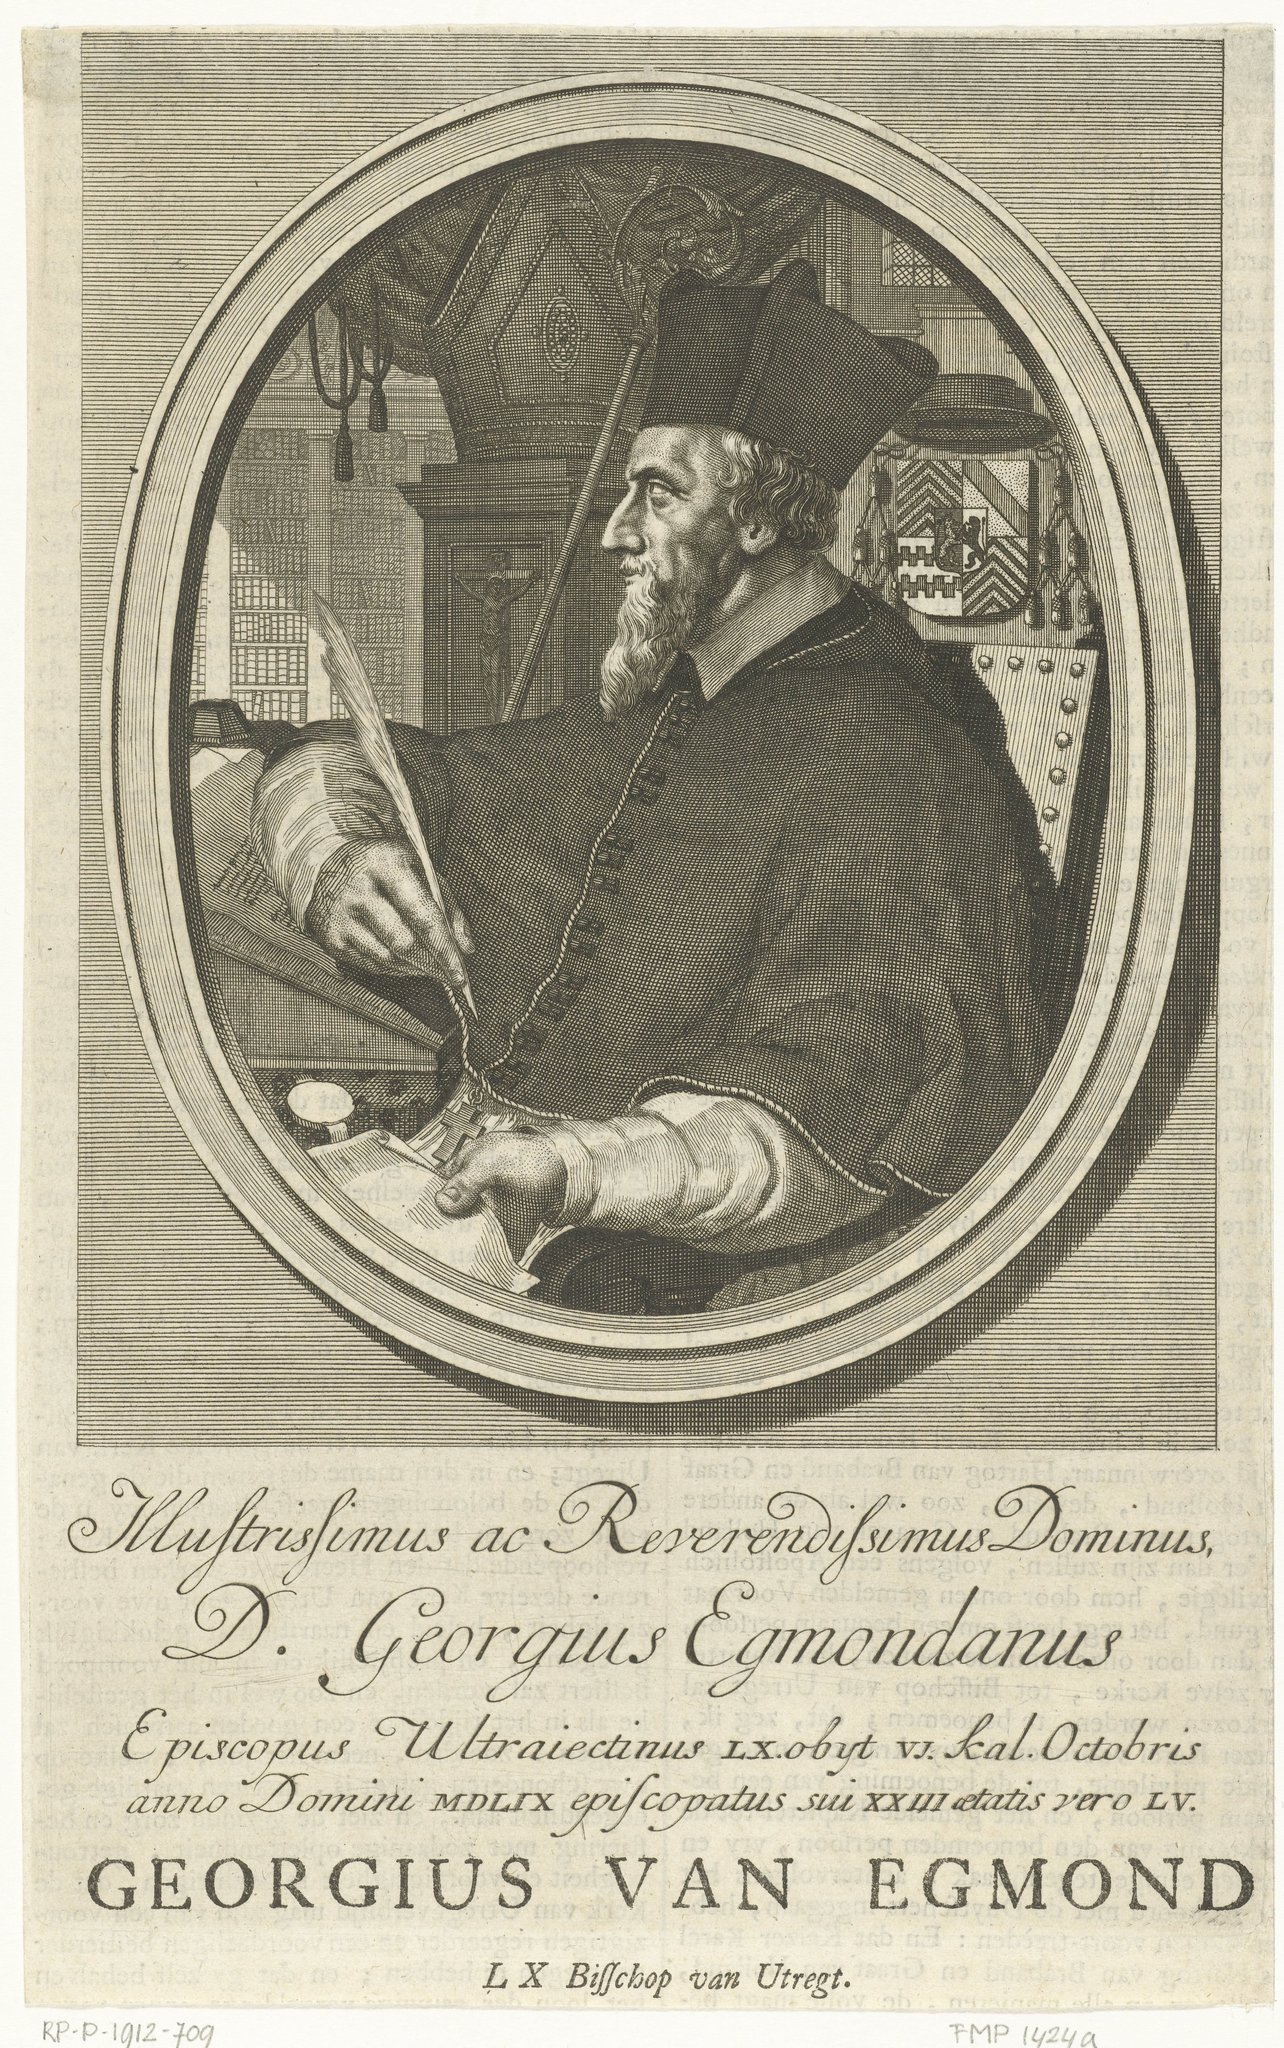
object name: book illustration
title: Portret van bisschop George van Egmond van Utrecht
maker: françois van bleyswijck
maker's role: draughtsman, print maker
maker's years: 1671-1746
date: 1681-1726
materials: paper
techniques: engraving, etching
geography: leiden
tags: george van egmond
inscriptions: collector's mark: Lugt 2228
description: Portret van bisschop George van Egmond (Georgius Egmondanus) van Utrecht zittend aan een schrijftafel met pen en papier in ovale omlijsting. Achter hem staan attributen van zijn functie, een kromstaf en mijter en zijn wapen.